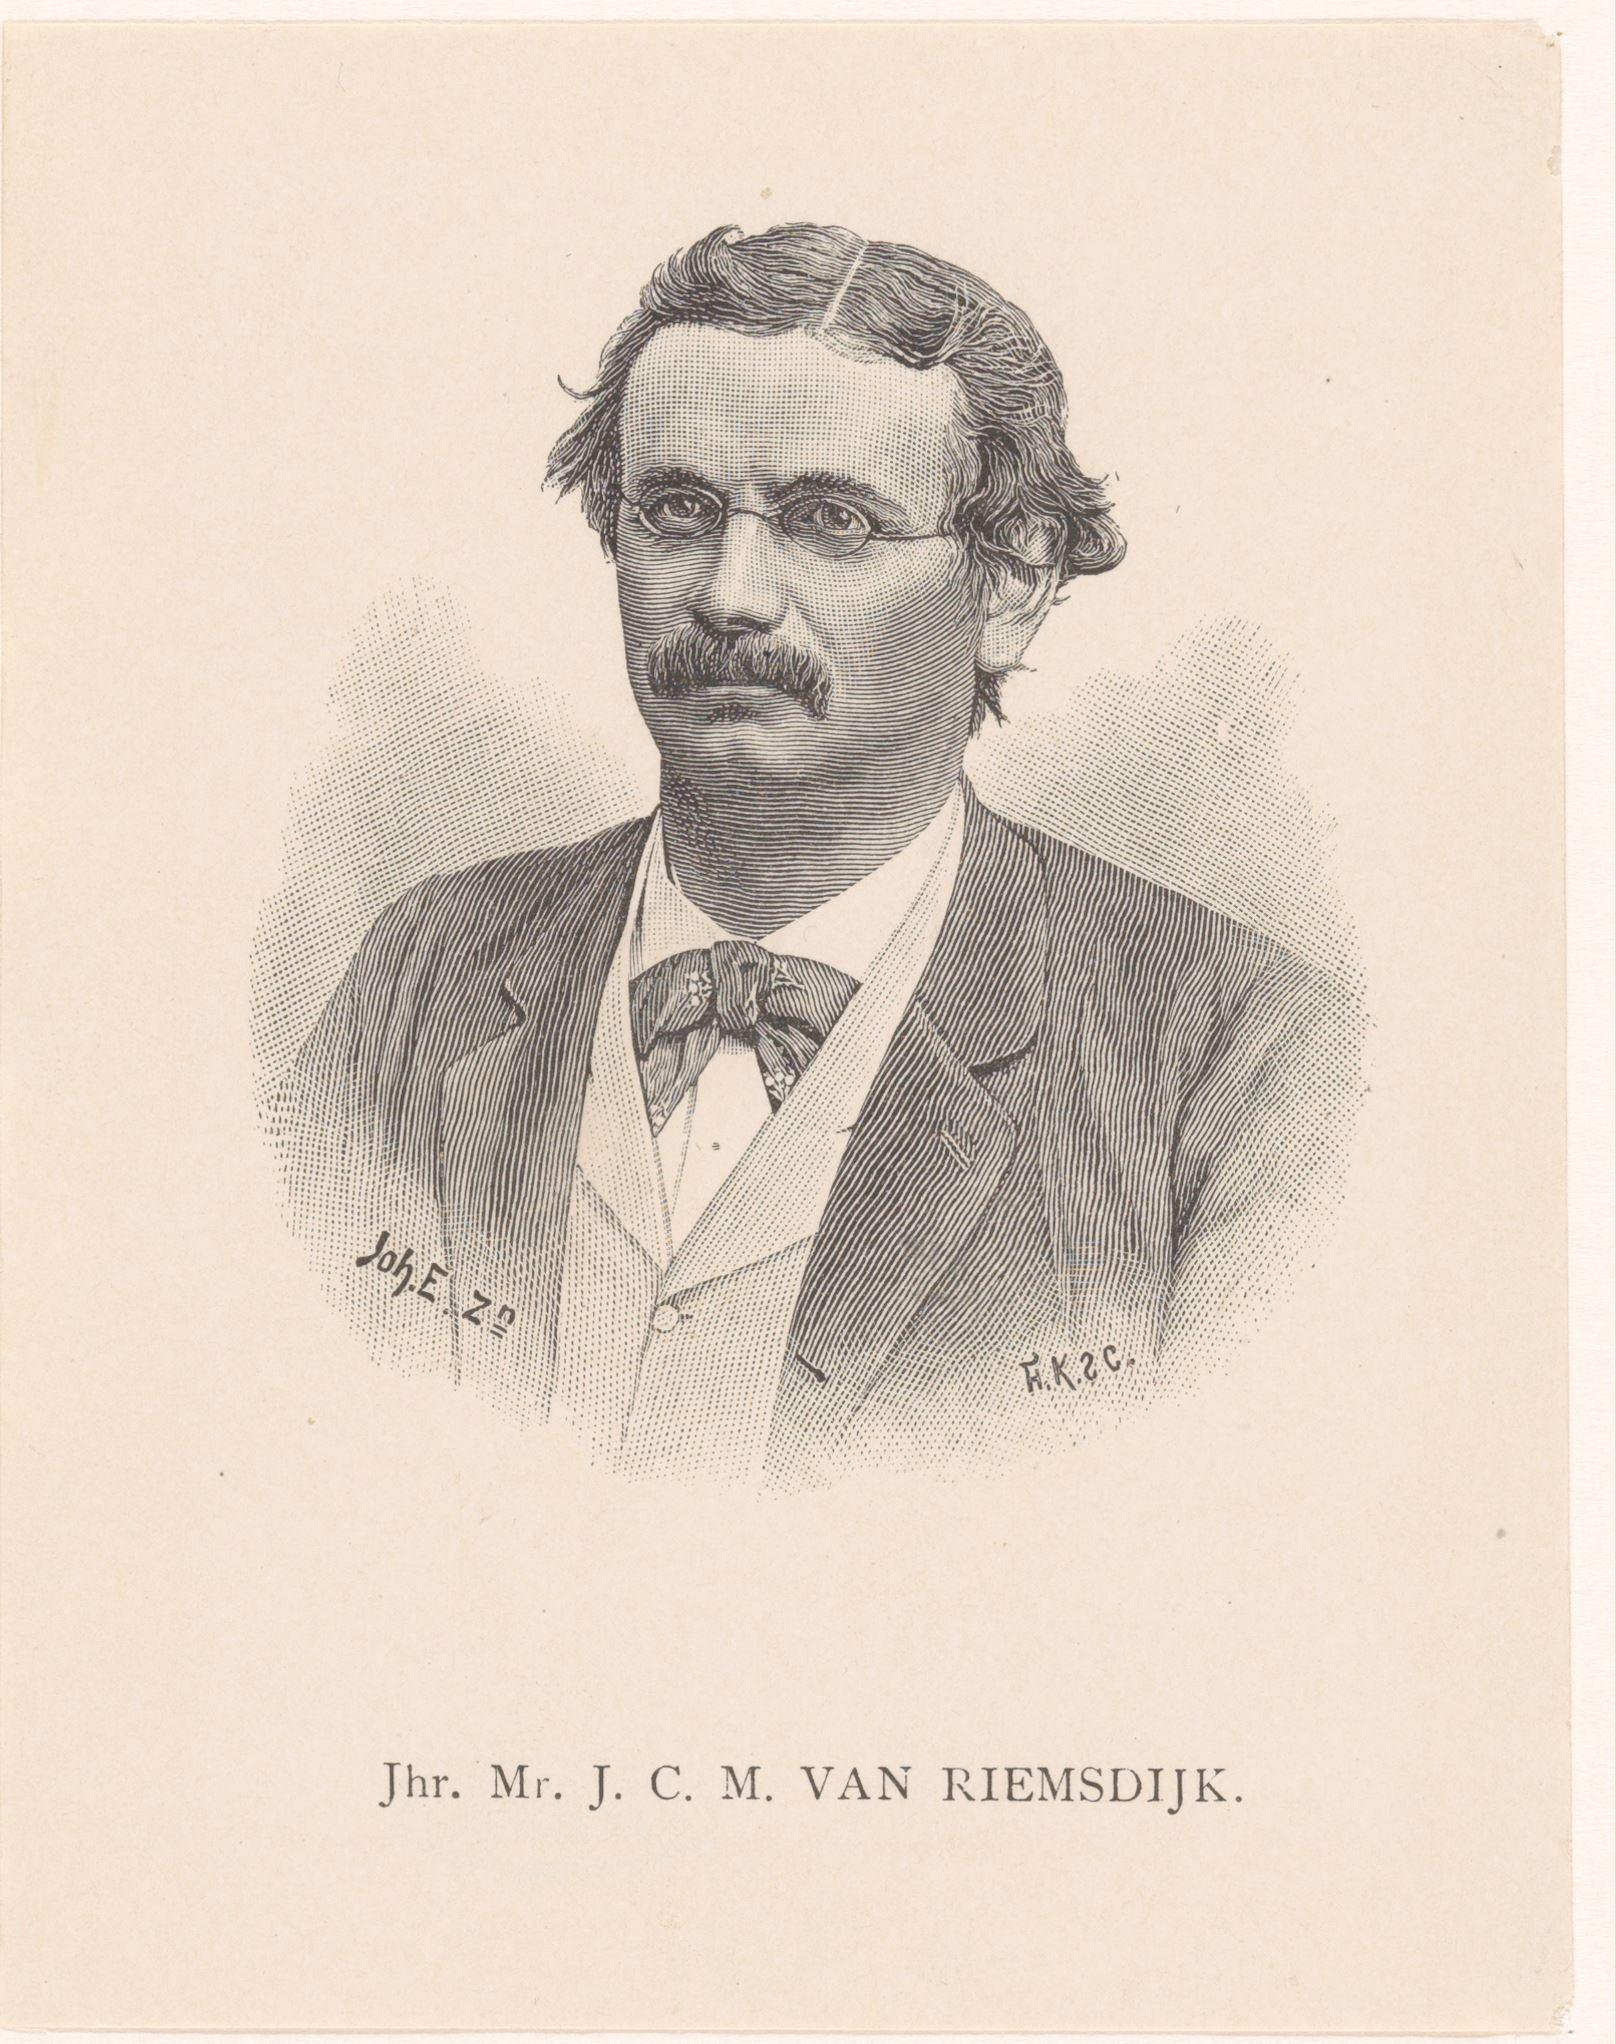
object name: print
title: Portret van Johannes Cornelis Marius van Riemsdijk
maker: theodorus henricus kerstel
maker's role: print maker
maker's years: 1859-1936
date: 1869-1936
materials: paper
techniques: lithograph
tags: historical persons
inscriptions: collector's mark: Lugt 2228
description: Een portret van jurist en musicus Johannes Cornelis Marius van Riemsdijk, met bril en snor.